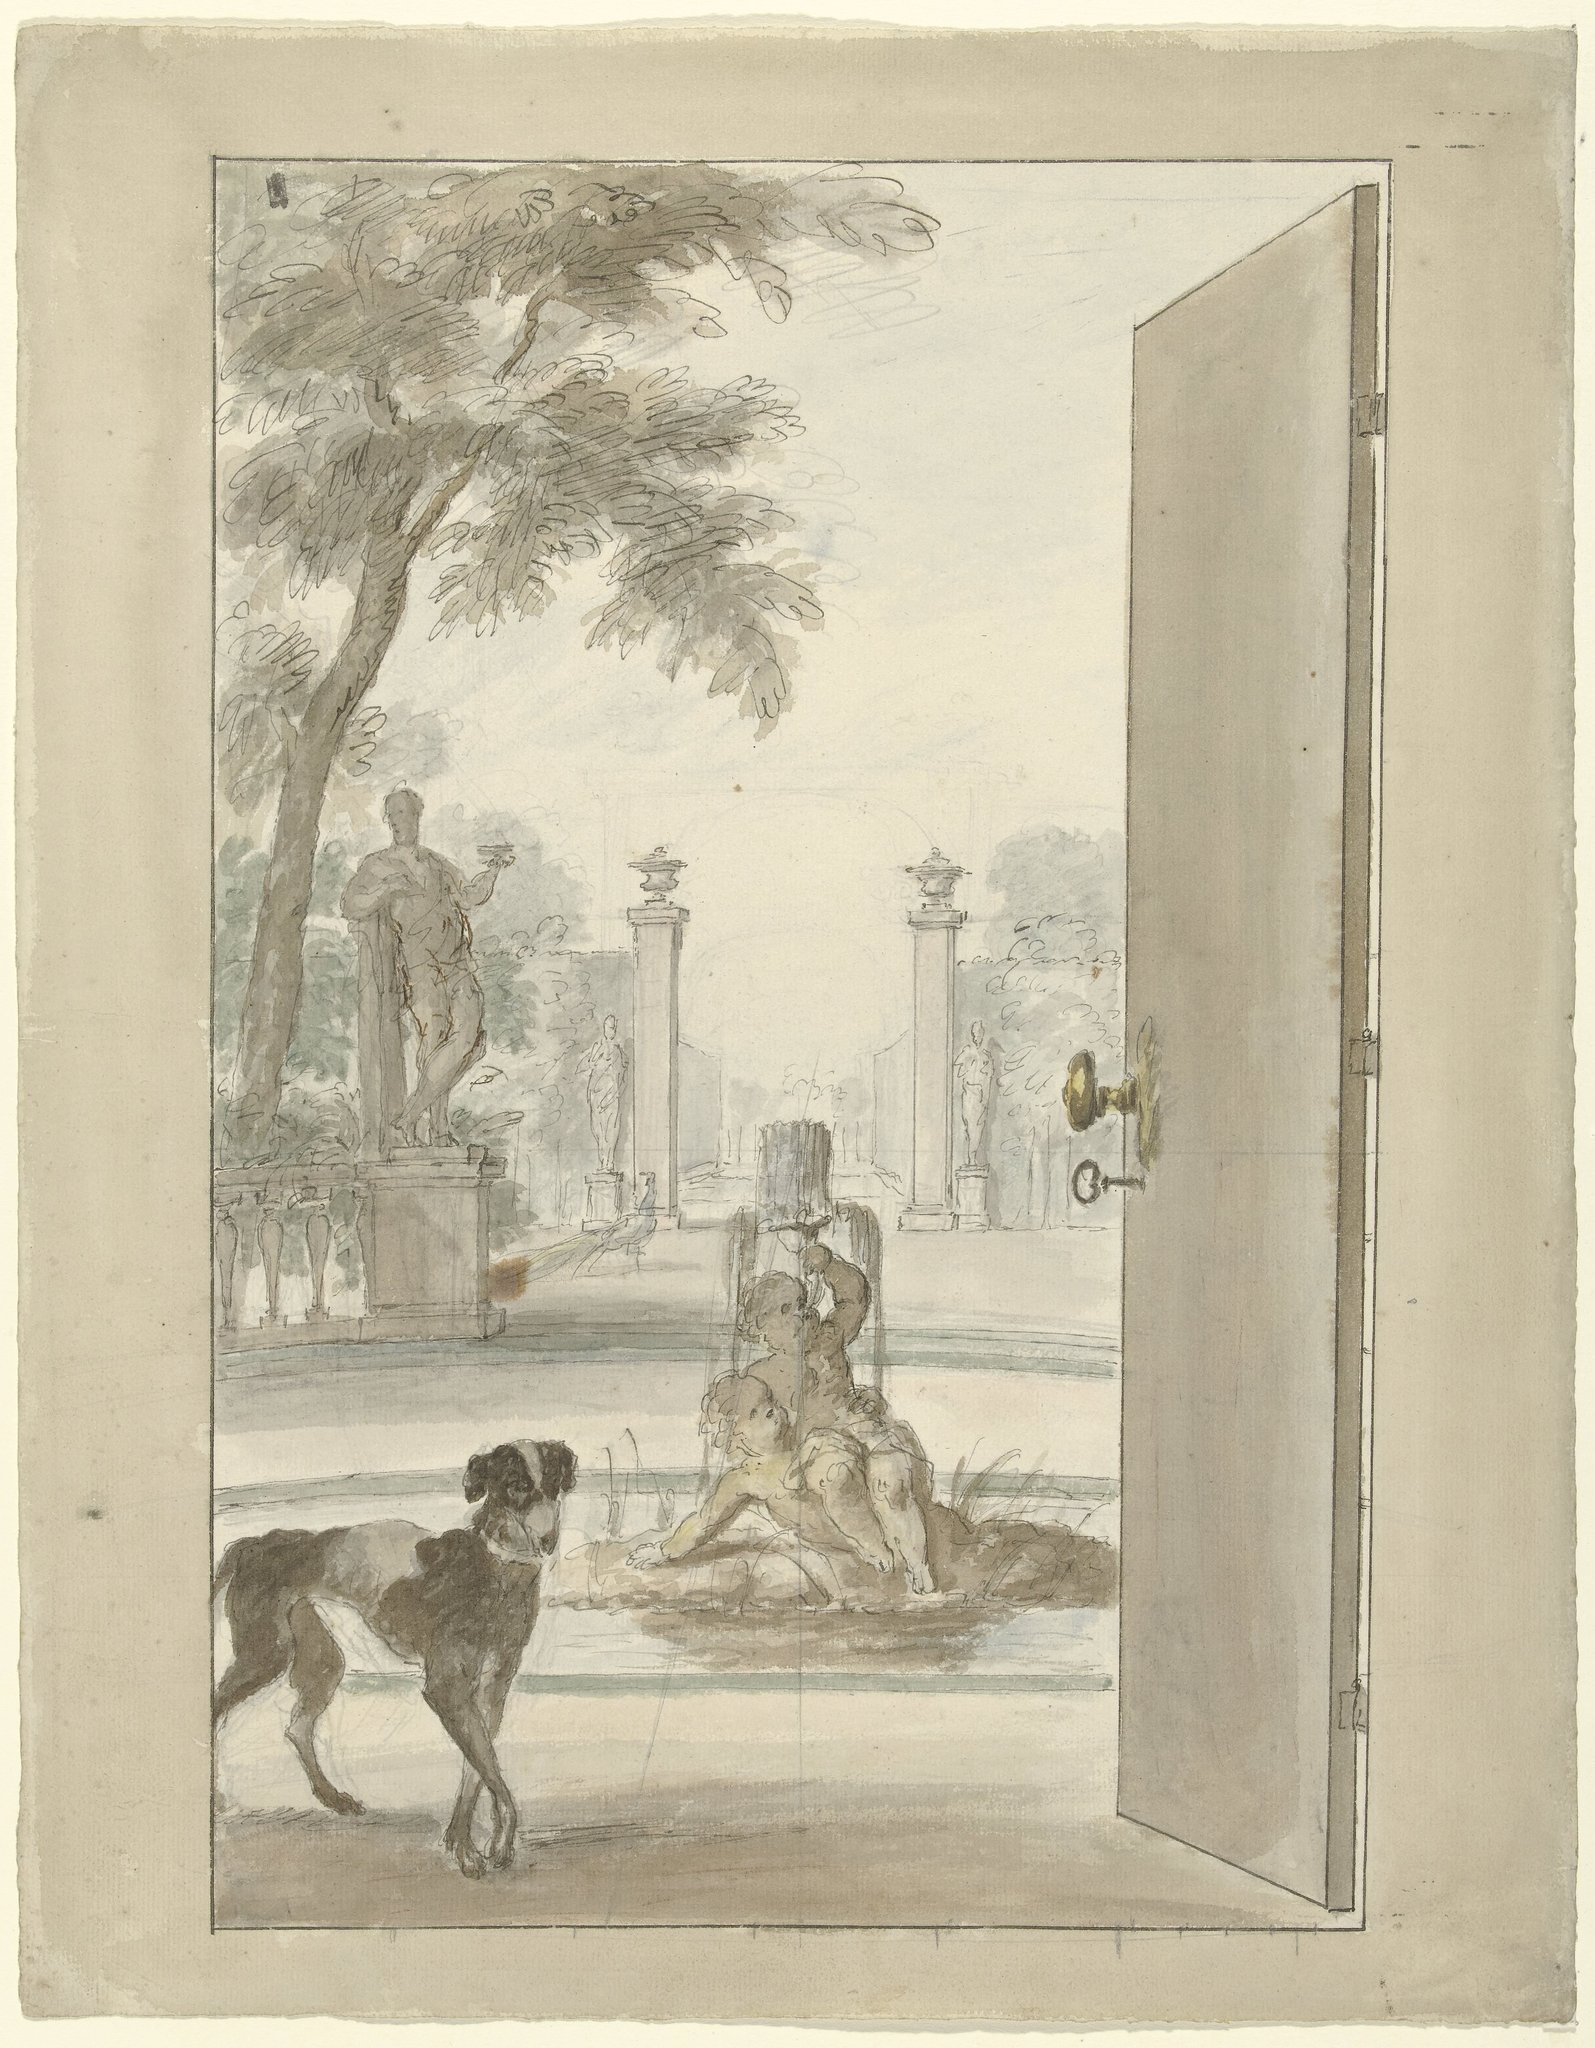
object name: drawing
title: Ontwerp voor een kamerbeschildering met gezicht door een openstaande deur op een fontein in een tuin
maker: dionys van nijmegen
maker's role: draughtsman, painter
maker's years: 1705-1798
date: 1715-1798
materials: ink, paper, pencil, watercolor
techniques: brush, pen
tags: garden fountain, dog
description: Ontwerp voor een kamerbeschildering: gezicht door een openstaande deur op een fontein in een tuin; bij de deur een hond.